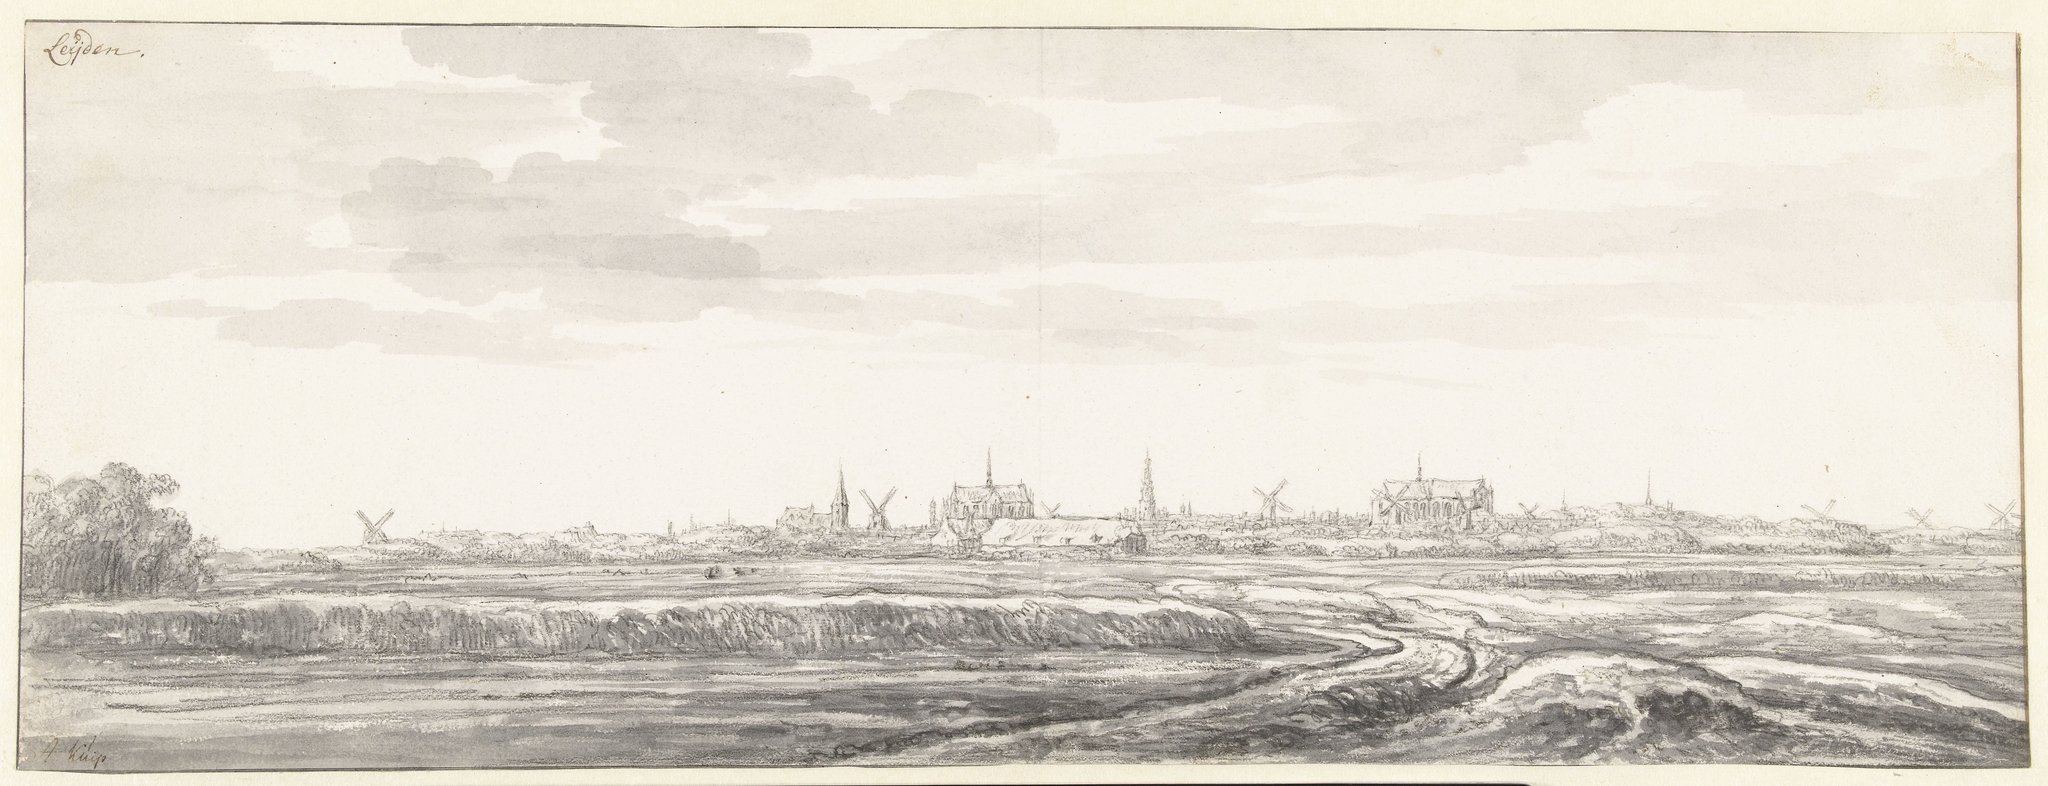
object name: drawing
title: View of Leiden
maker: aelbert cuyp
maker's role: draughtsman, painter, print maker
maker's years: 1620-1691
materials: chalk, paper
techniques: brush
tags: leiden